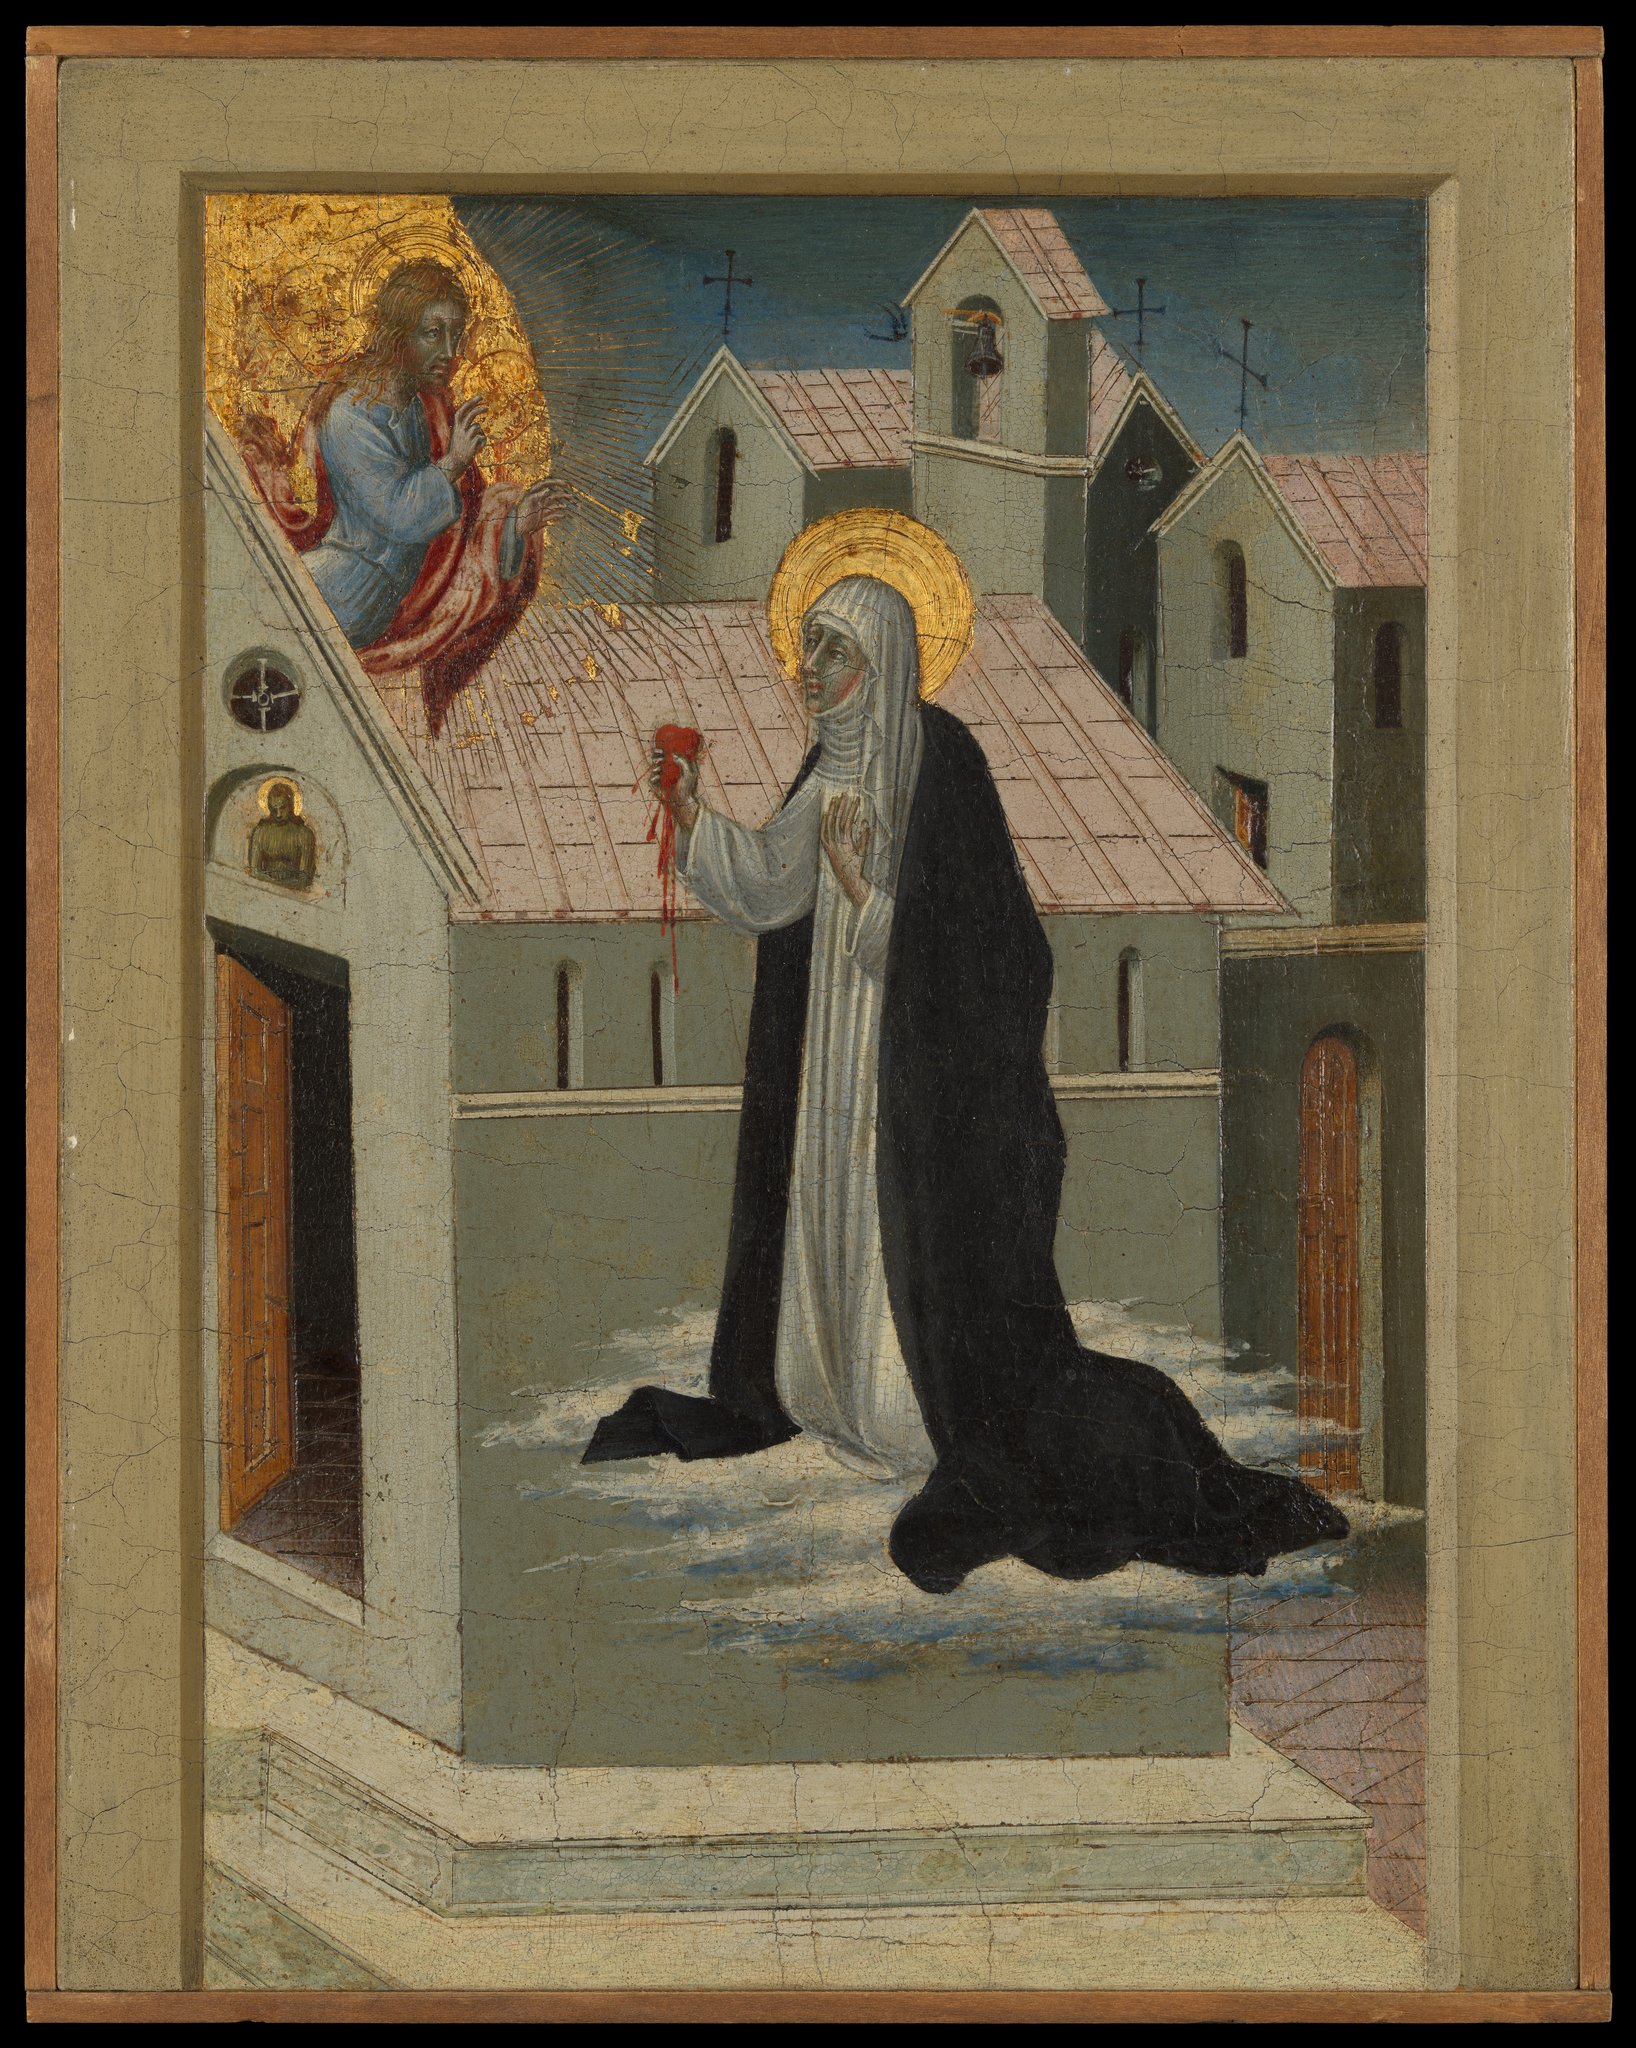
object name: painting, predella panel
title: Saint Catherine of Siena Exchanging Her Heart with Christ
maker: giovanni di paolo (giovanni di paolo di grazia)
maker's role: artist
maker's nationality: italian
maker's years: 1398-1482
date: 1417-1482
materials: gold, paint, wood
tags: churches,christ,saint catherine